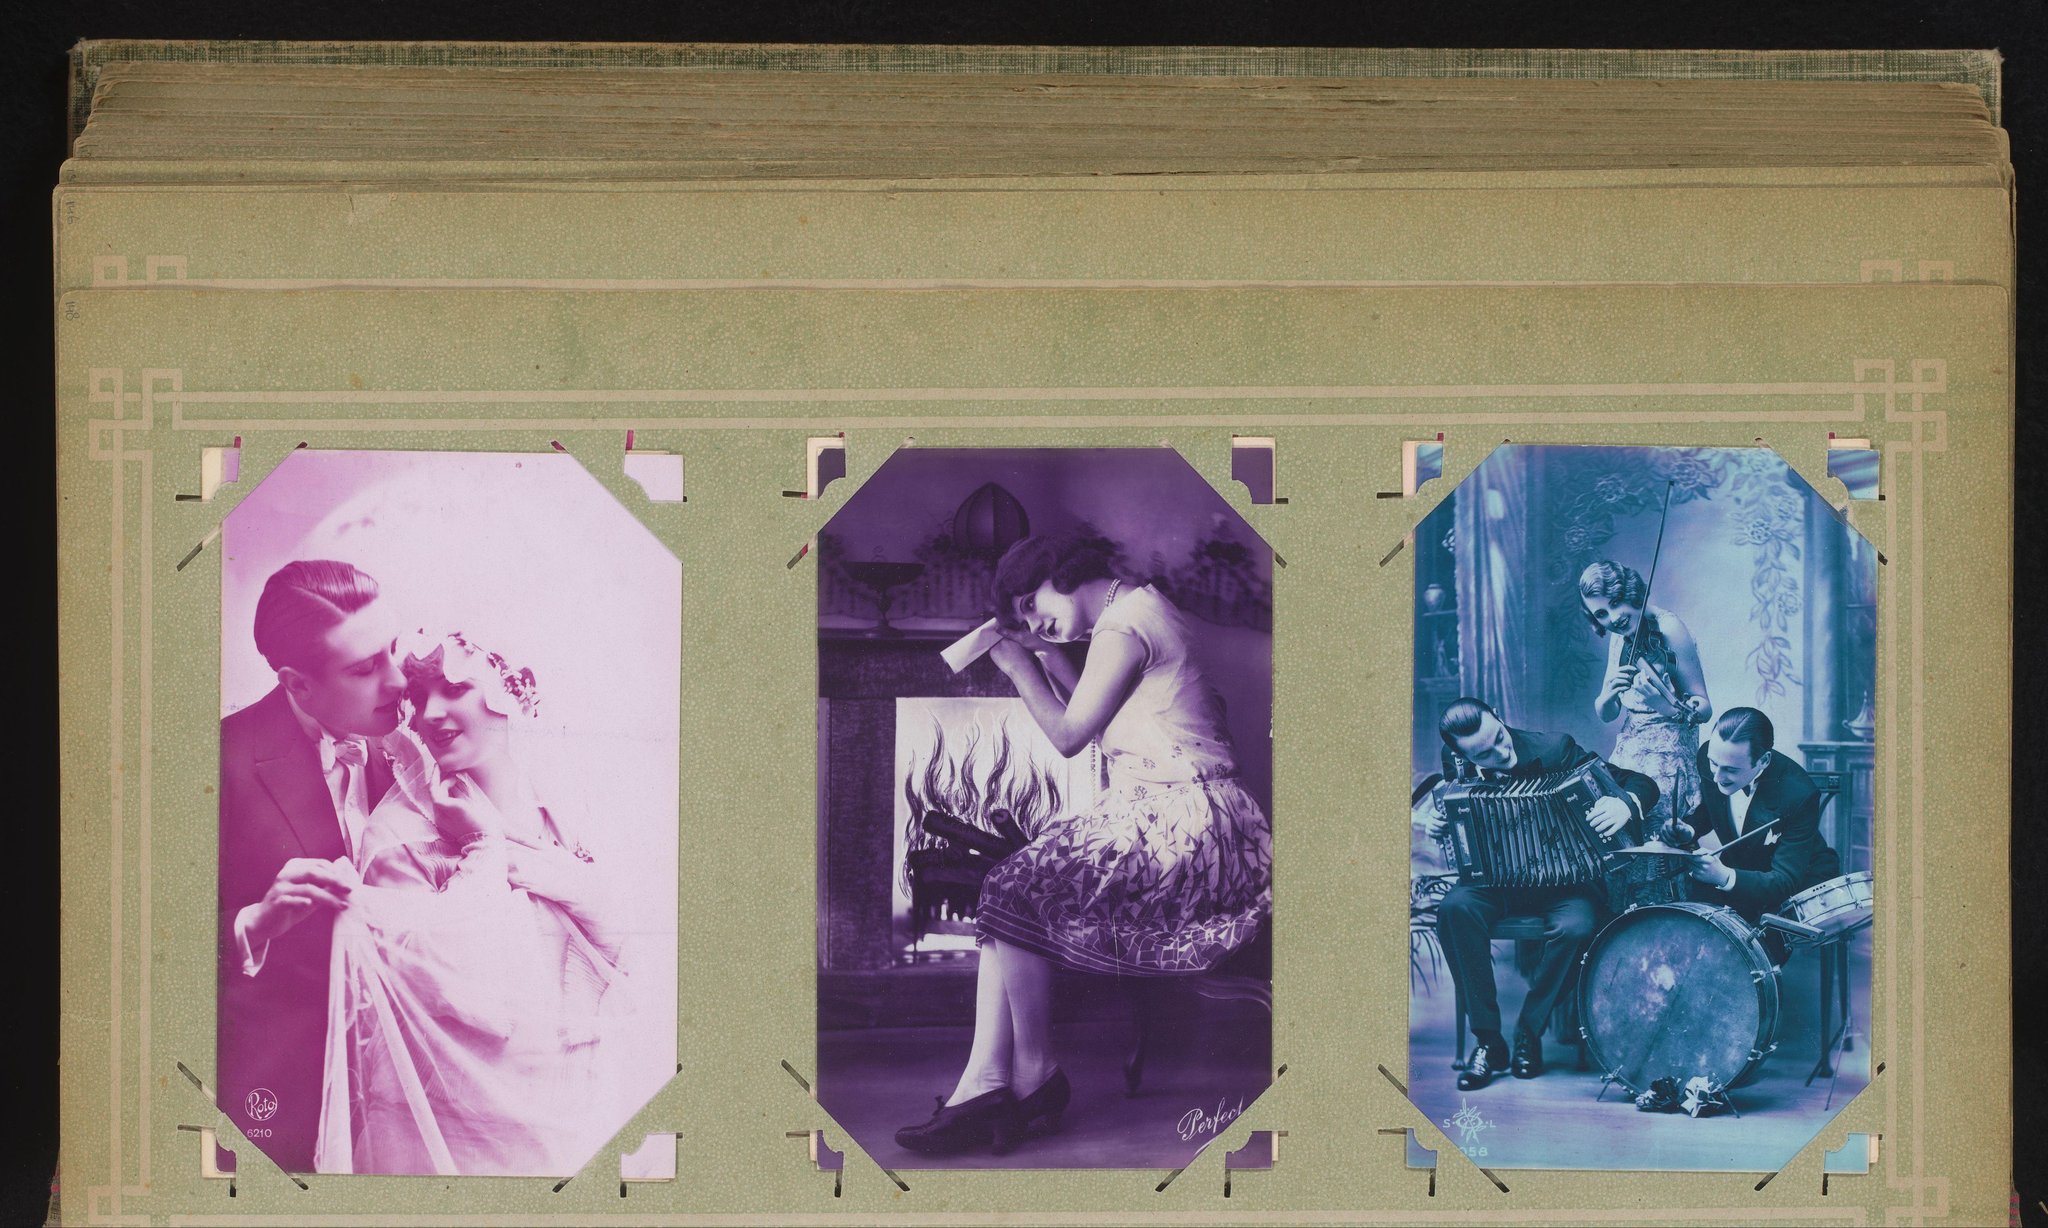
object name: album leaf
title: Portret van een paar geliefden, portret van een jonge vrouw voor een open haard en een portret van drie musicerende personen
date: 1900-1930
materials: cardboard, photographic support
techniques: gelatin silver print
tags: small group of musicians, chamber orchestra, jazz band, historical persons - bb - woman, couple of lovers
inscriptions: monogram: ‘S [...] L’, name: ‘Perfect’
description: Deze foto's maken deel uit van een album.